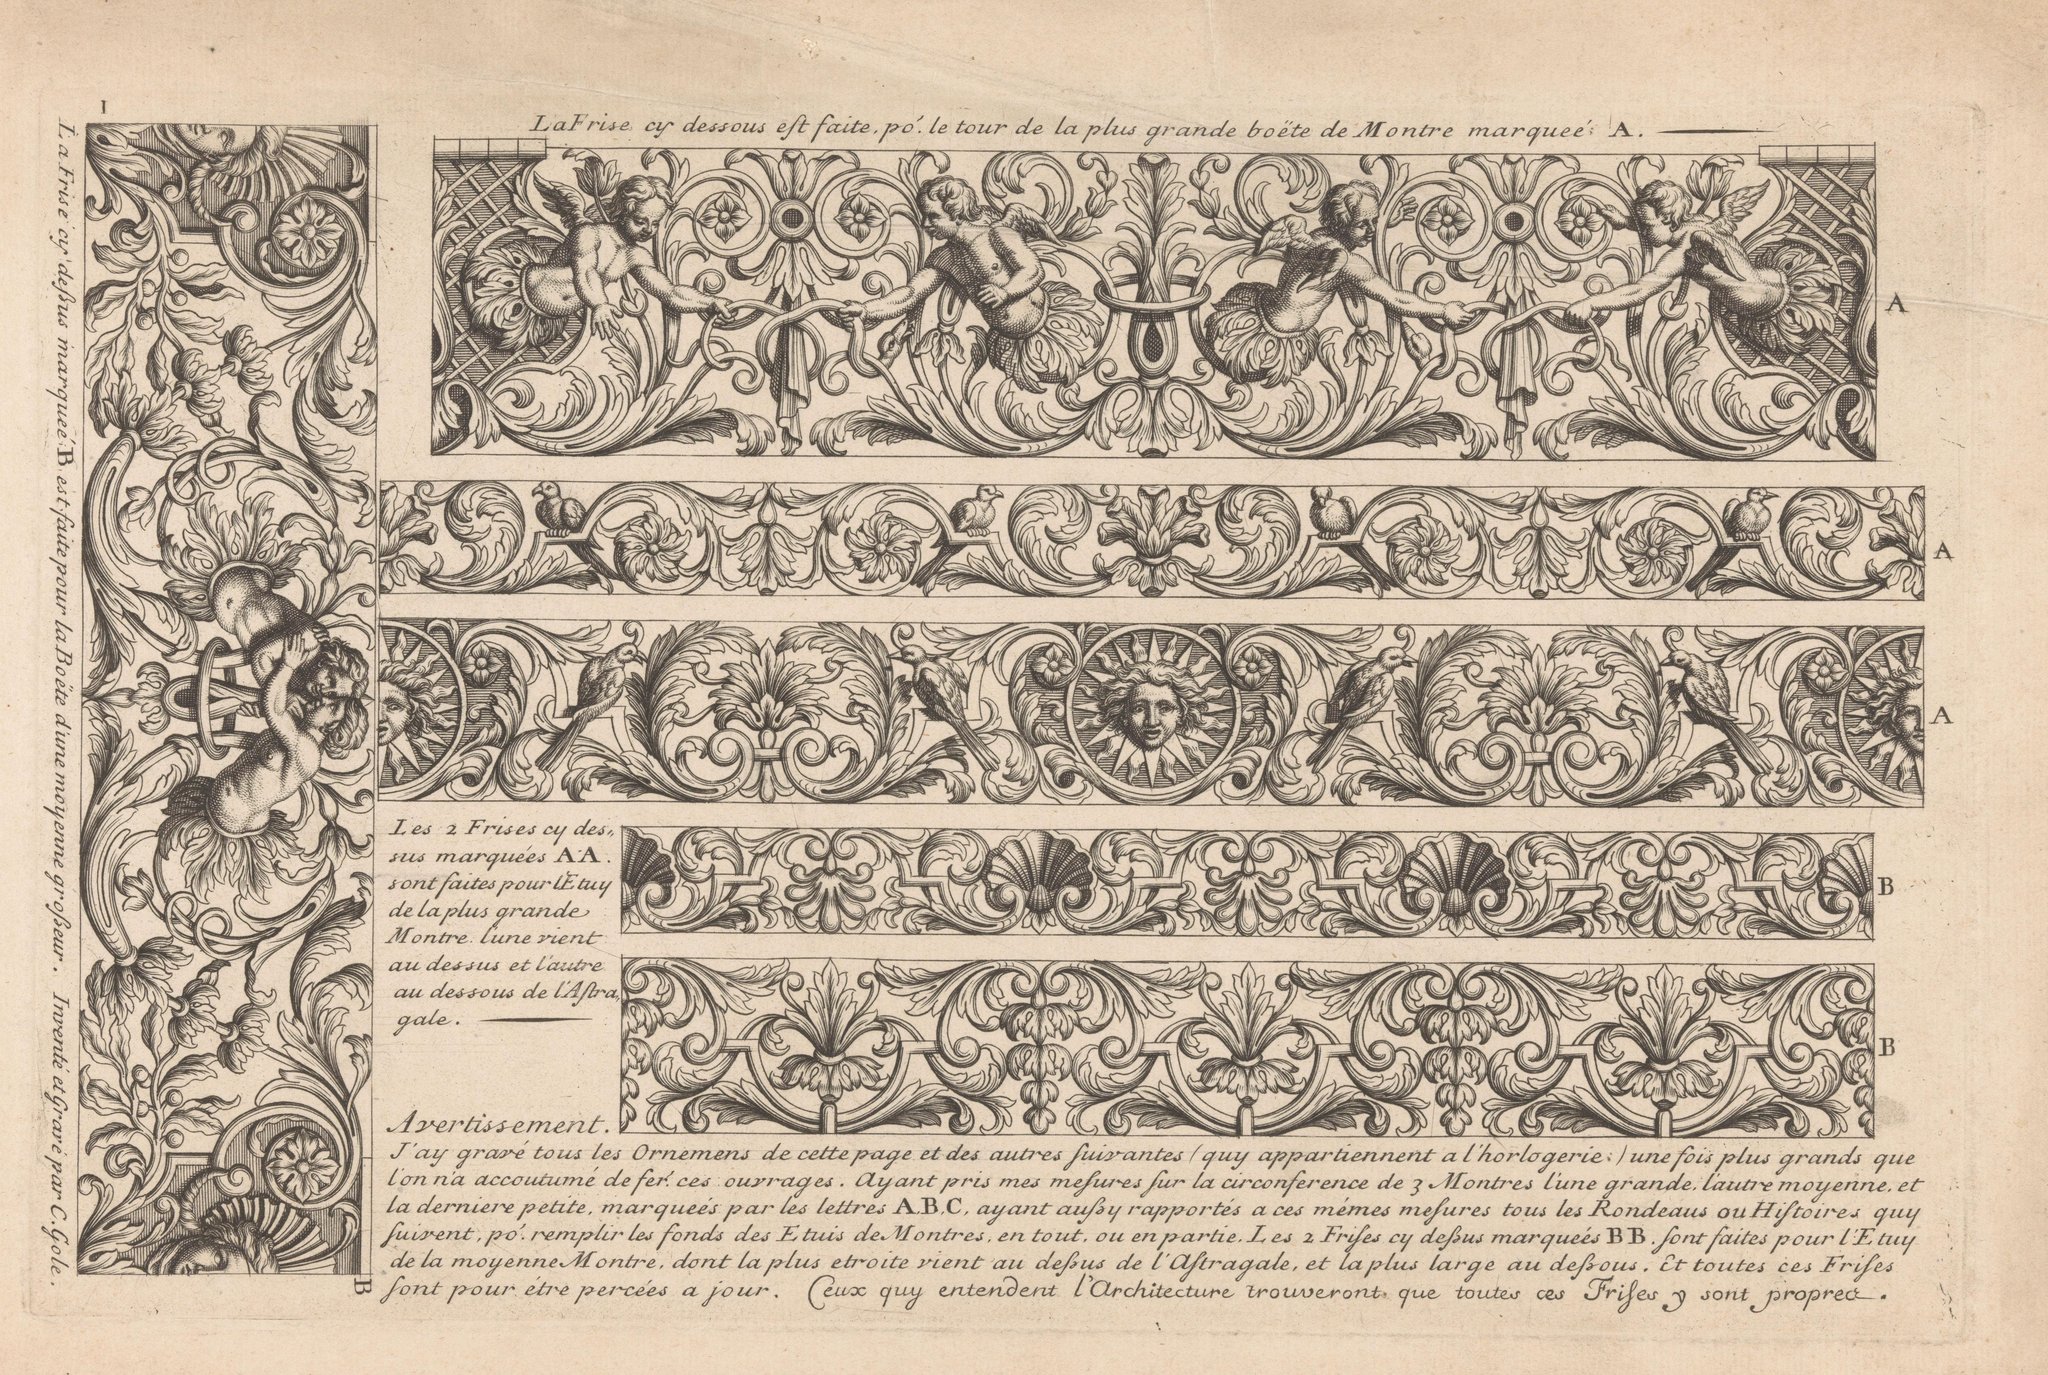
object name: ornament print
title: Zes friezen met putti, vogels en Apollomaskers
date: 1737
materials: paper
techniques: engraving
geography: london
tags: ornament ~ arabesque, birds, mask, mascaron ~ ornament, cupids: 'amores', 'amoretti', 'putti'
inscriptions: collector's mark: Lugt 2228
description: Zes friezen gedecoreerd met arabesken, schelpmotieven, putti, vogels en Apollomaskers. Met Franse beschrijving.